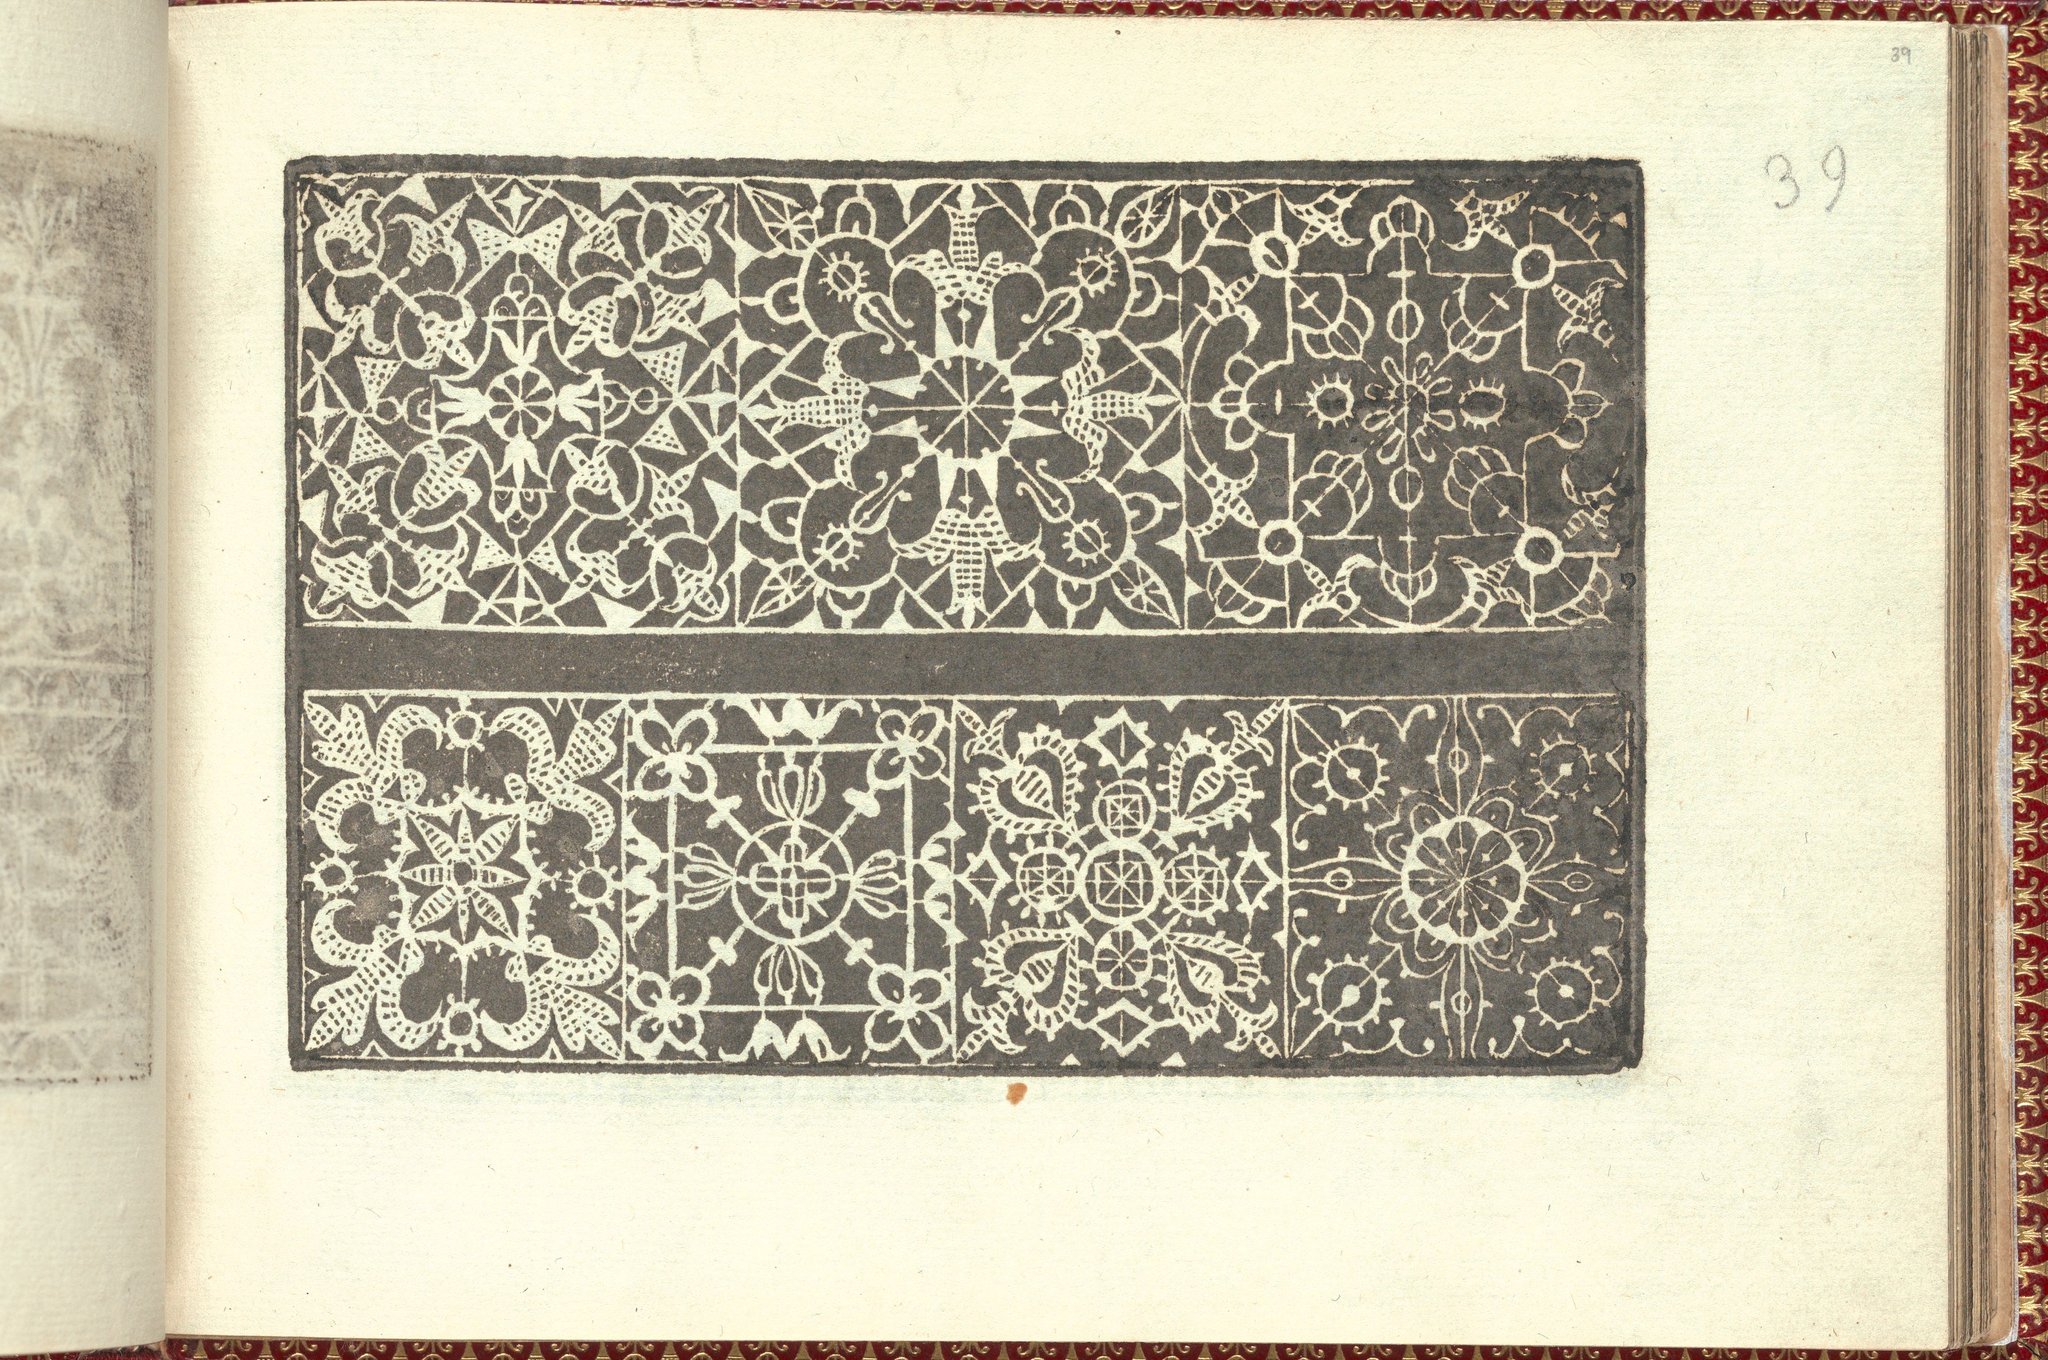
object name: book print ornament architecture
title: Corona delle Nobili et Virtuose Donne: Libro I-IV, page 39 (recto)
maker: cesare vecellio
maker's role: publisher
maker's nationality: italian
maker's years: 1521-1601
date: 1601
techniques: woodcut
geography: italy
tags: flowers